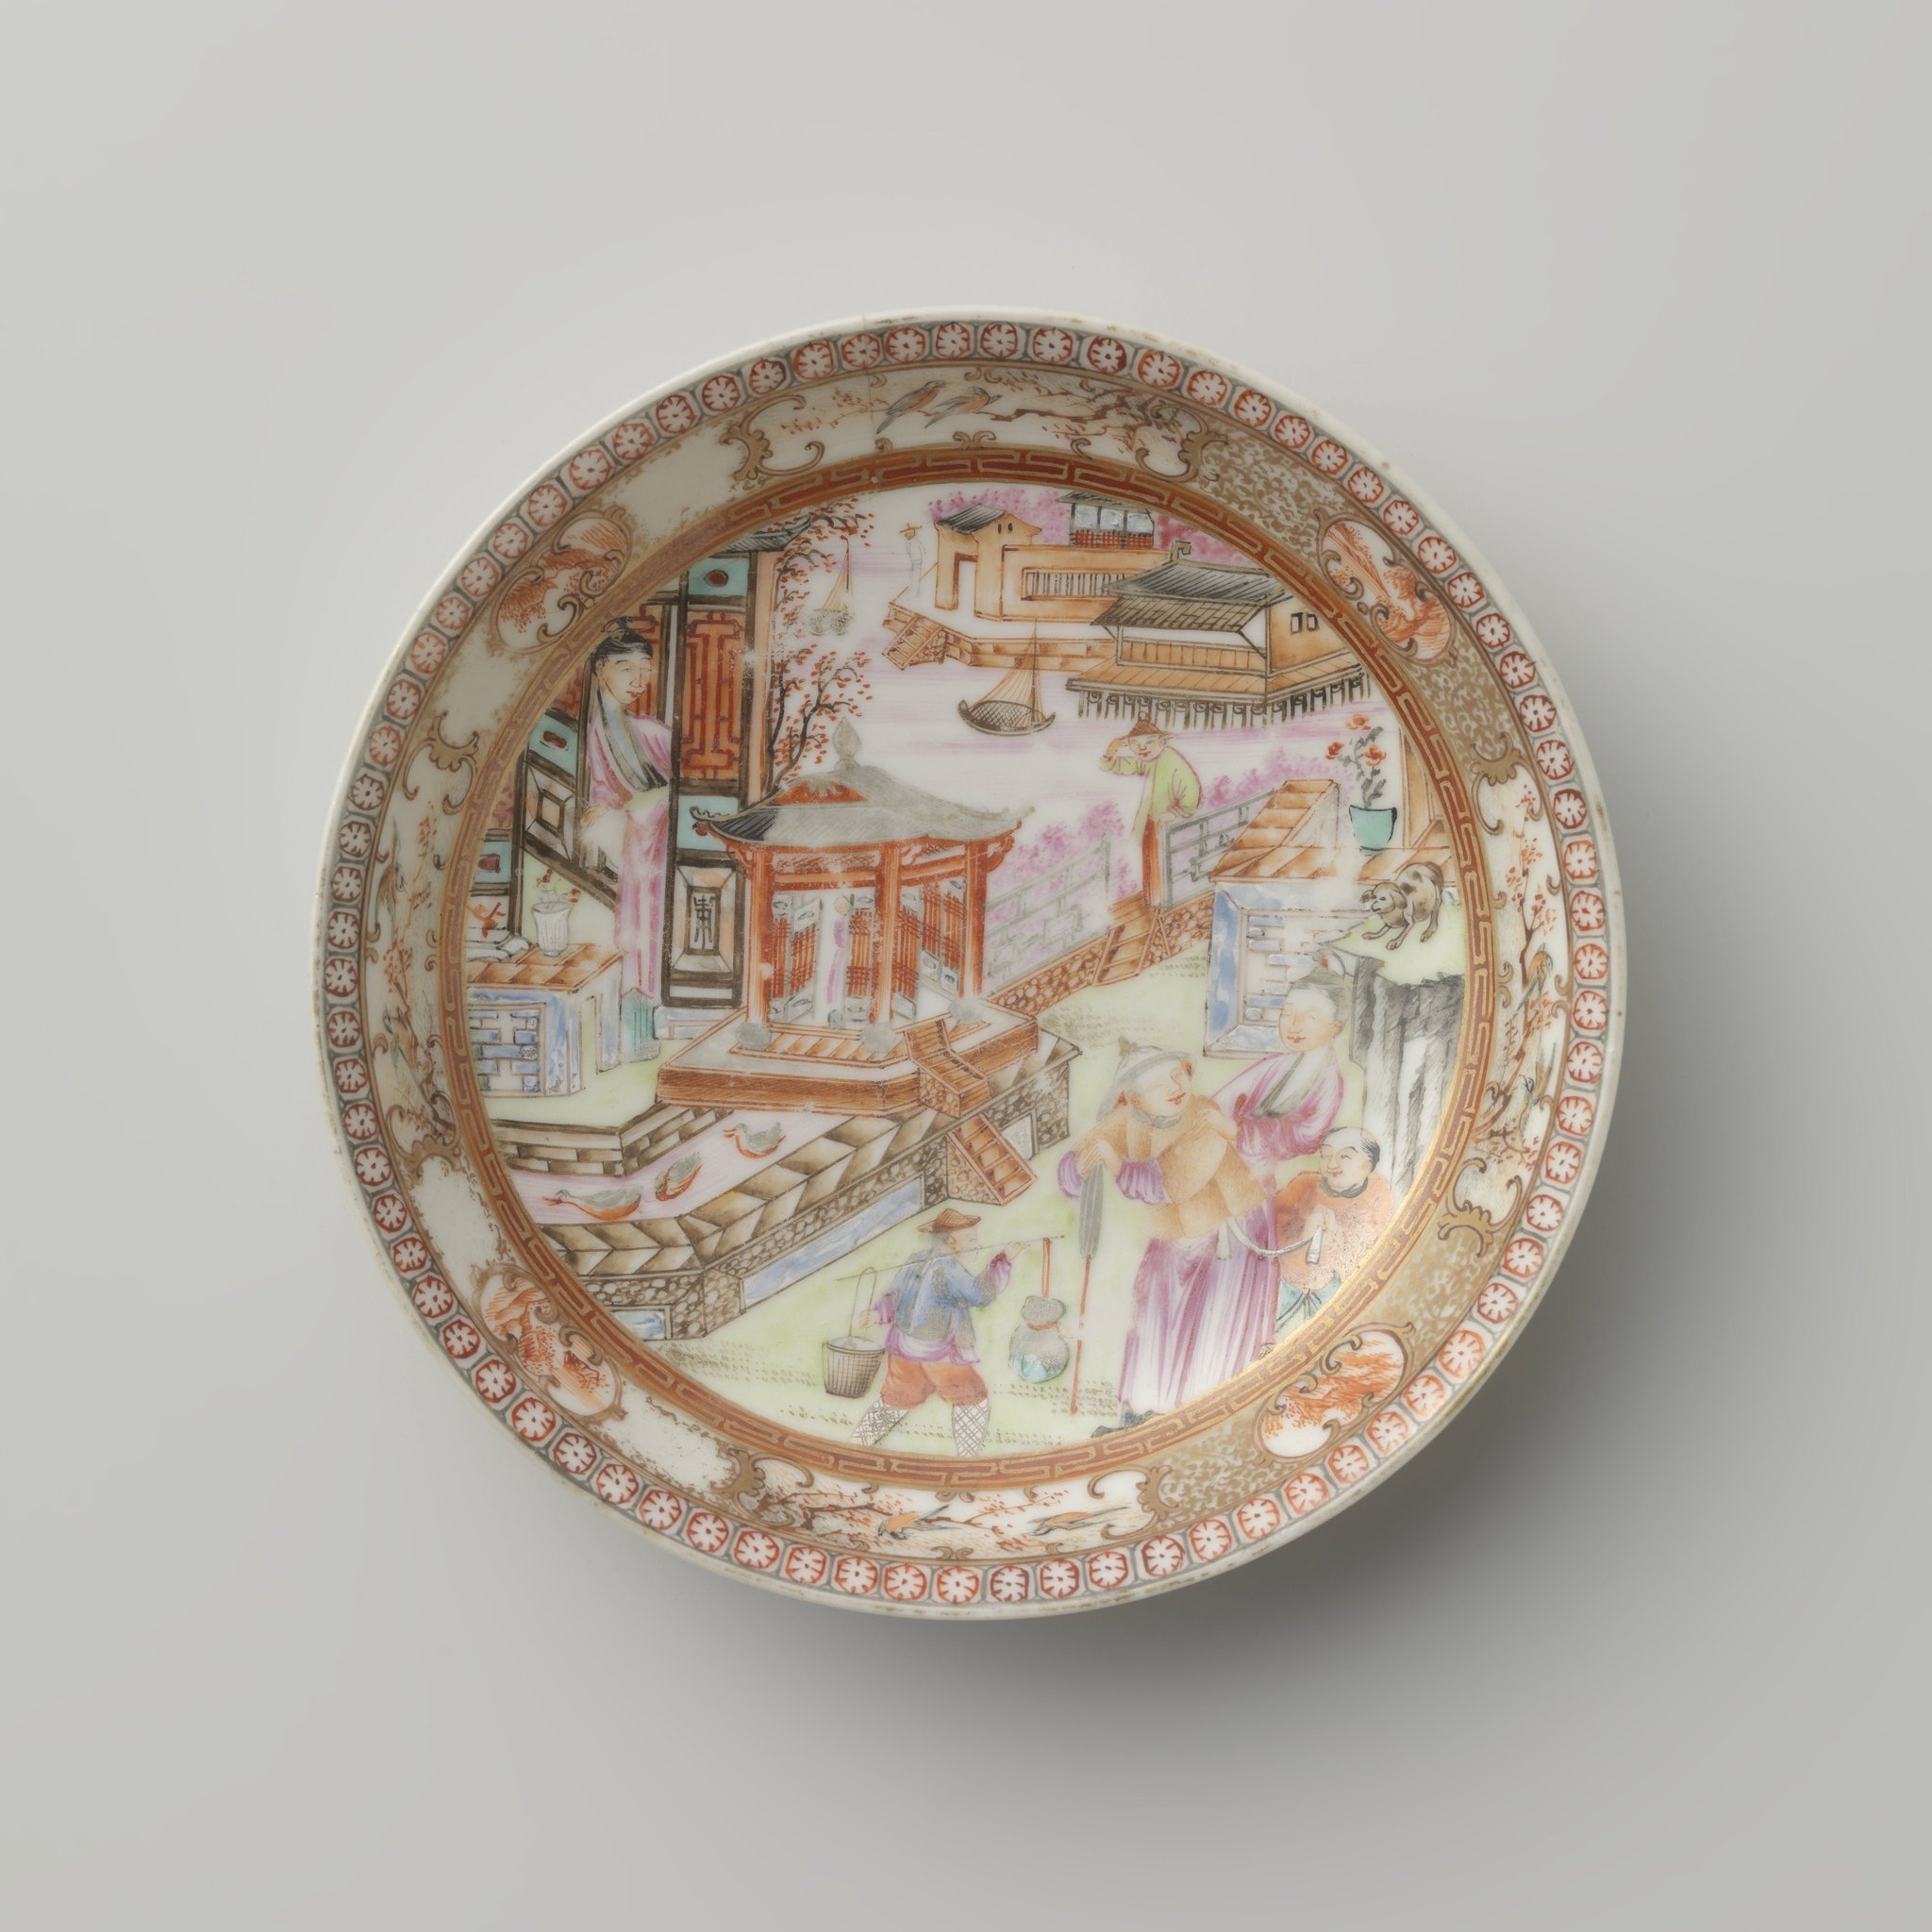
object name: platter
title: Saucer with figuren and animals near pavilion at the waterside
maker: Anonymous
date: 1775-1799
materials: glaze, gold, paint, porcelain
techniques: firing, gilding, turning, vitrification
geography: china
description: Kop en schotel,, mandarijnporselijn, het plat met figuren en huizen in kleuren en goud.